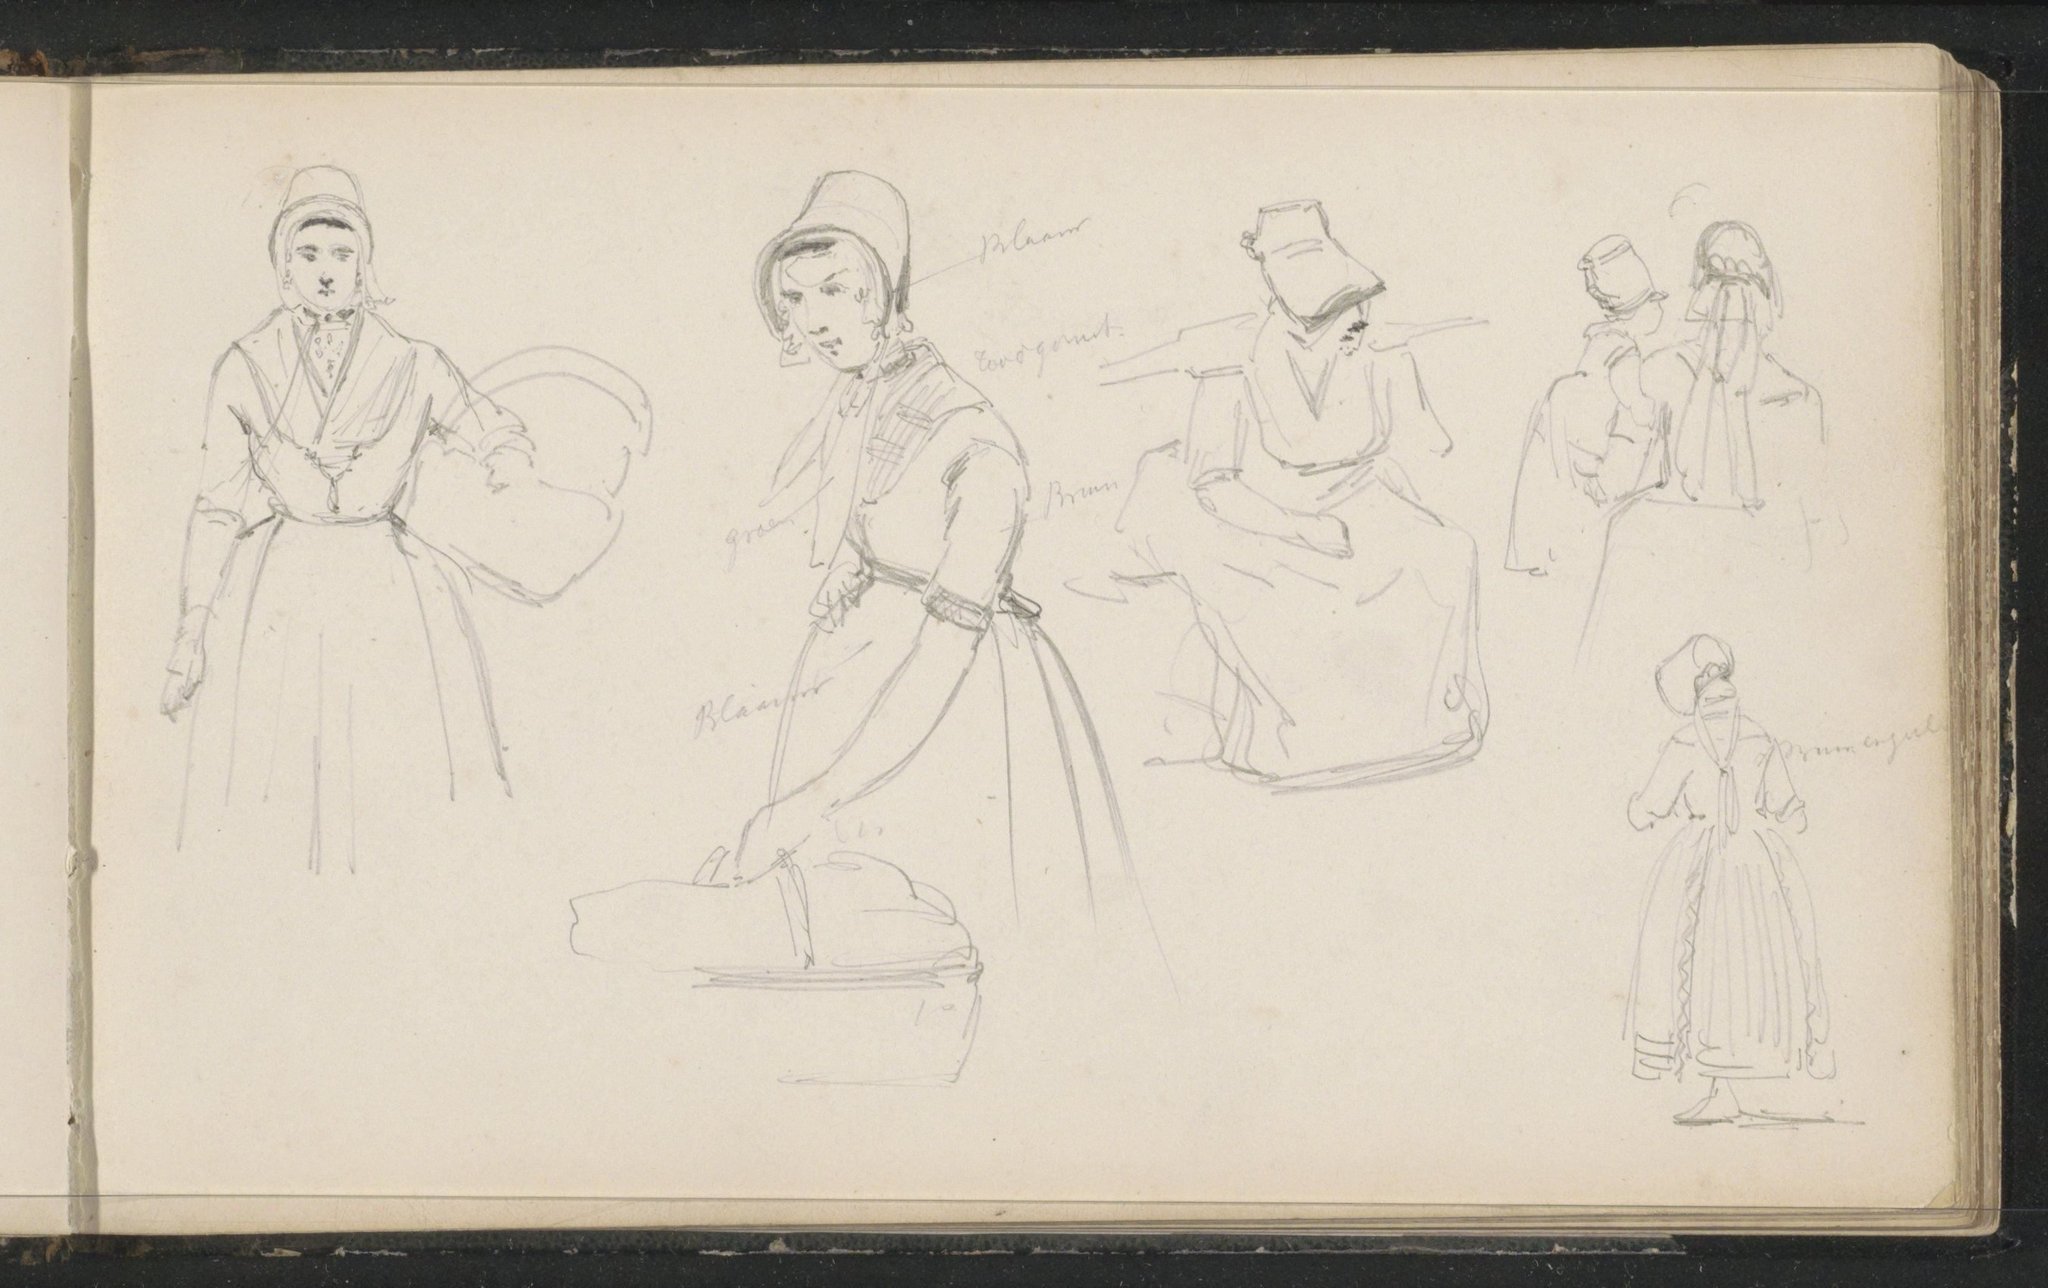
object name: sketchbook leaf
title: Vrouwen in Zeeuwse kostuums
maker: cornelis springer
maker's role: draughtsman, painter, print maker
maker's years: 1817-1891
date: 1856-1861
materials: paper, pencil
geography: zeeland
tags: adult woman, clothes, costume (+ women's clothes)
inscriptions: kleurnotitie, handgeschreven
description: Vrouwen in Zeeuwse kostuums. Blad 7 uit een schetsboek met 44 bladen vervaardigd in Zeeland en Utrecht.